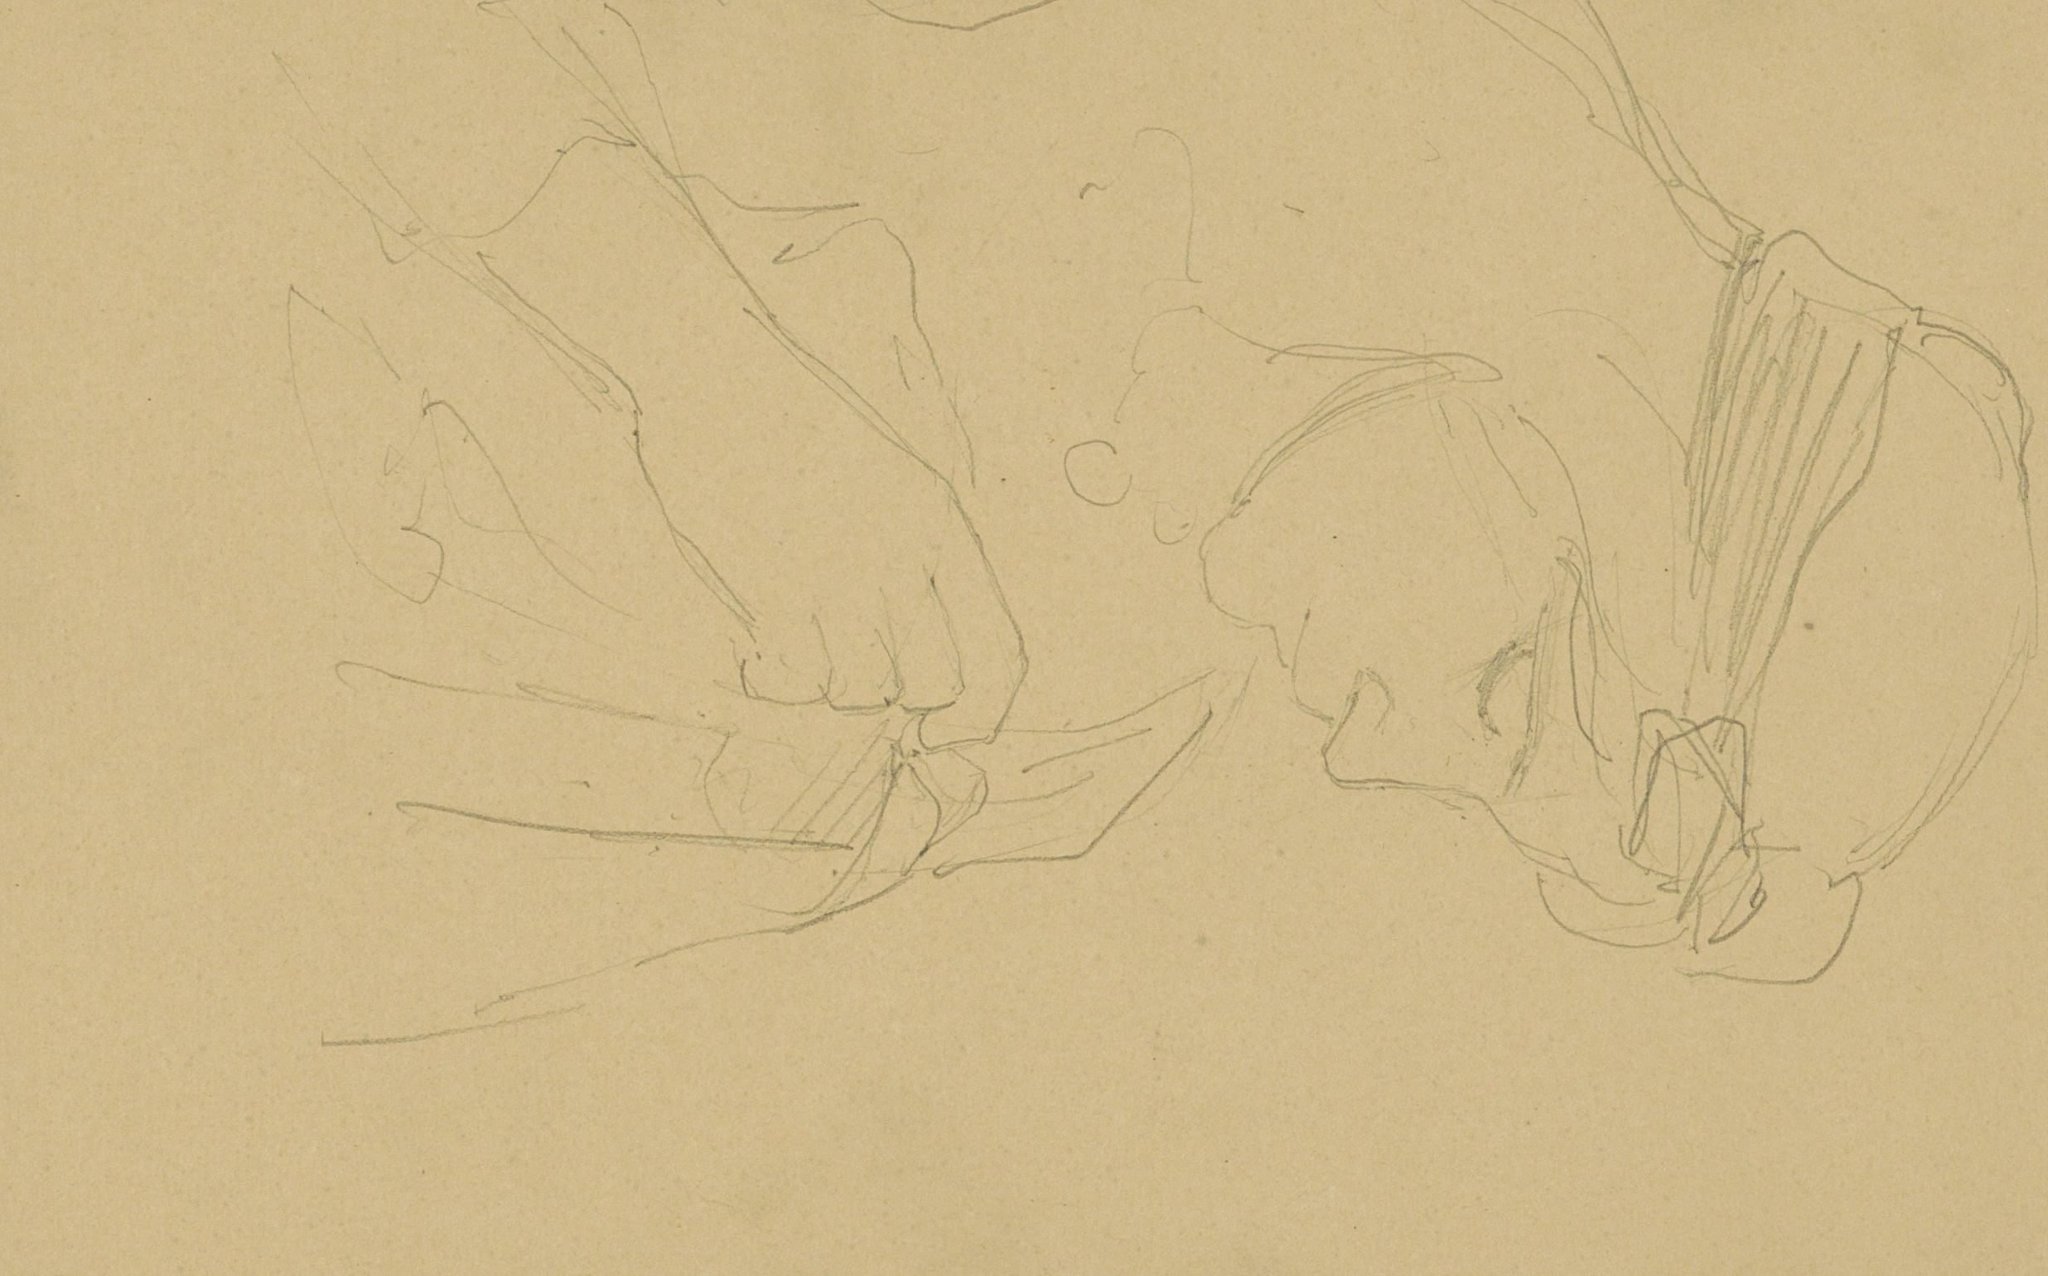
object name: sketchbook leaf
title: Handwerkende vrouw met een strik op het haar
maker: a.a.l. de grammont-hubrecht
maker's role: draughtsman, painter, print maker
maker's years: 1855-1913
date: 1865-1913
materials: chalk, paper, pencil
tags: adult woman, bow (ornamental part of clothing), home sewing; repair of clothes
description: Blad 25 verso uit een schetsboek met 28 bladen.